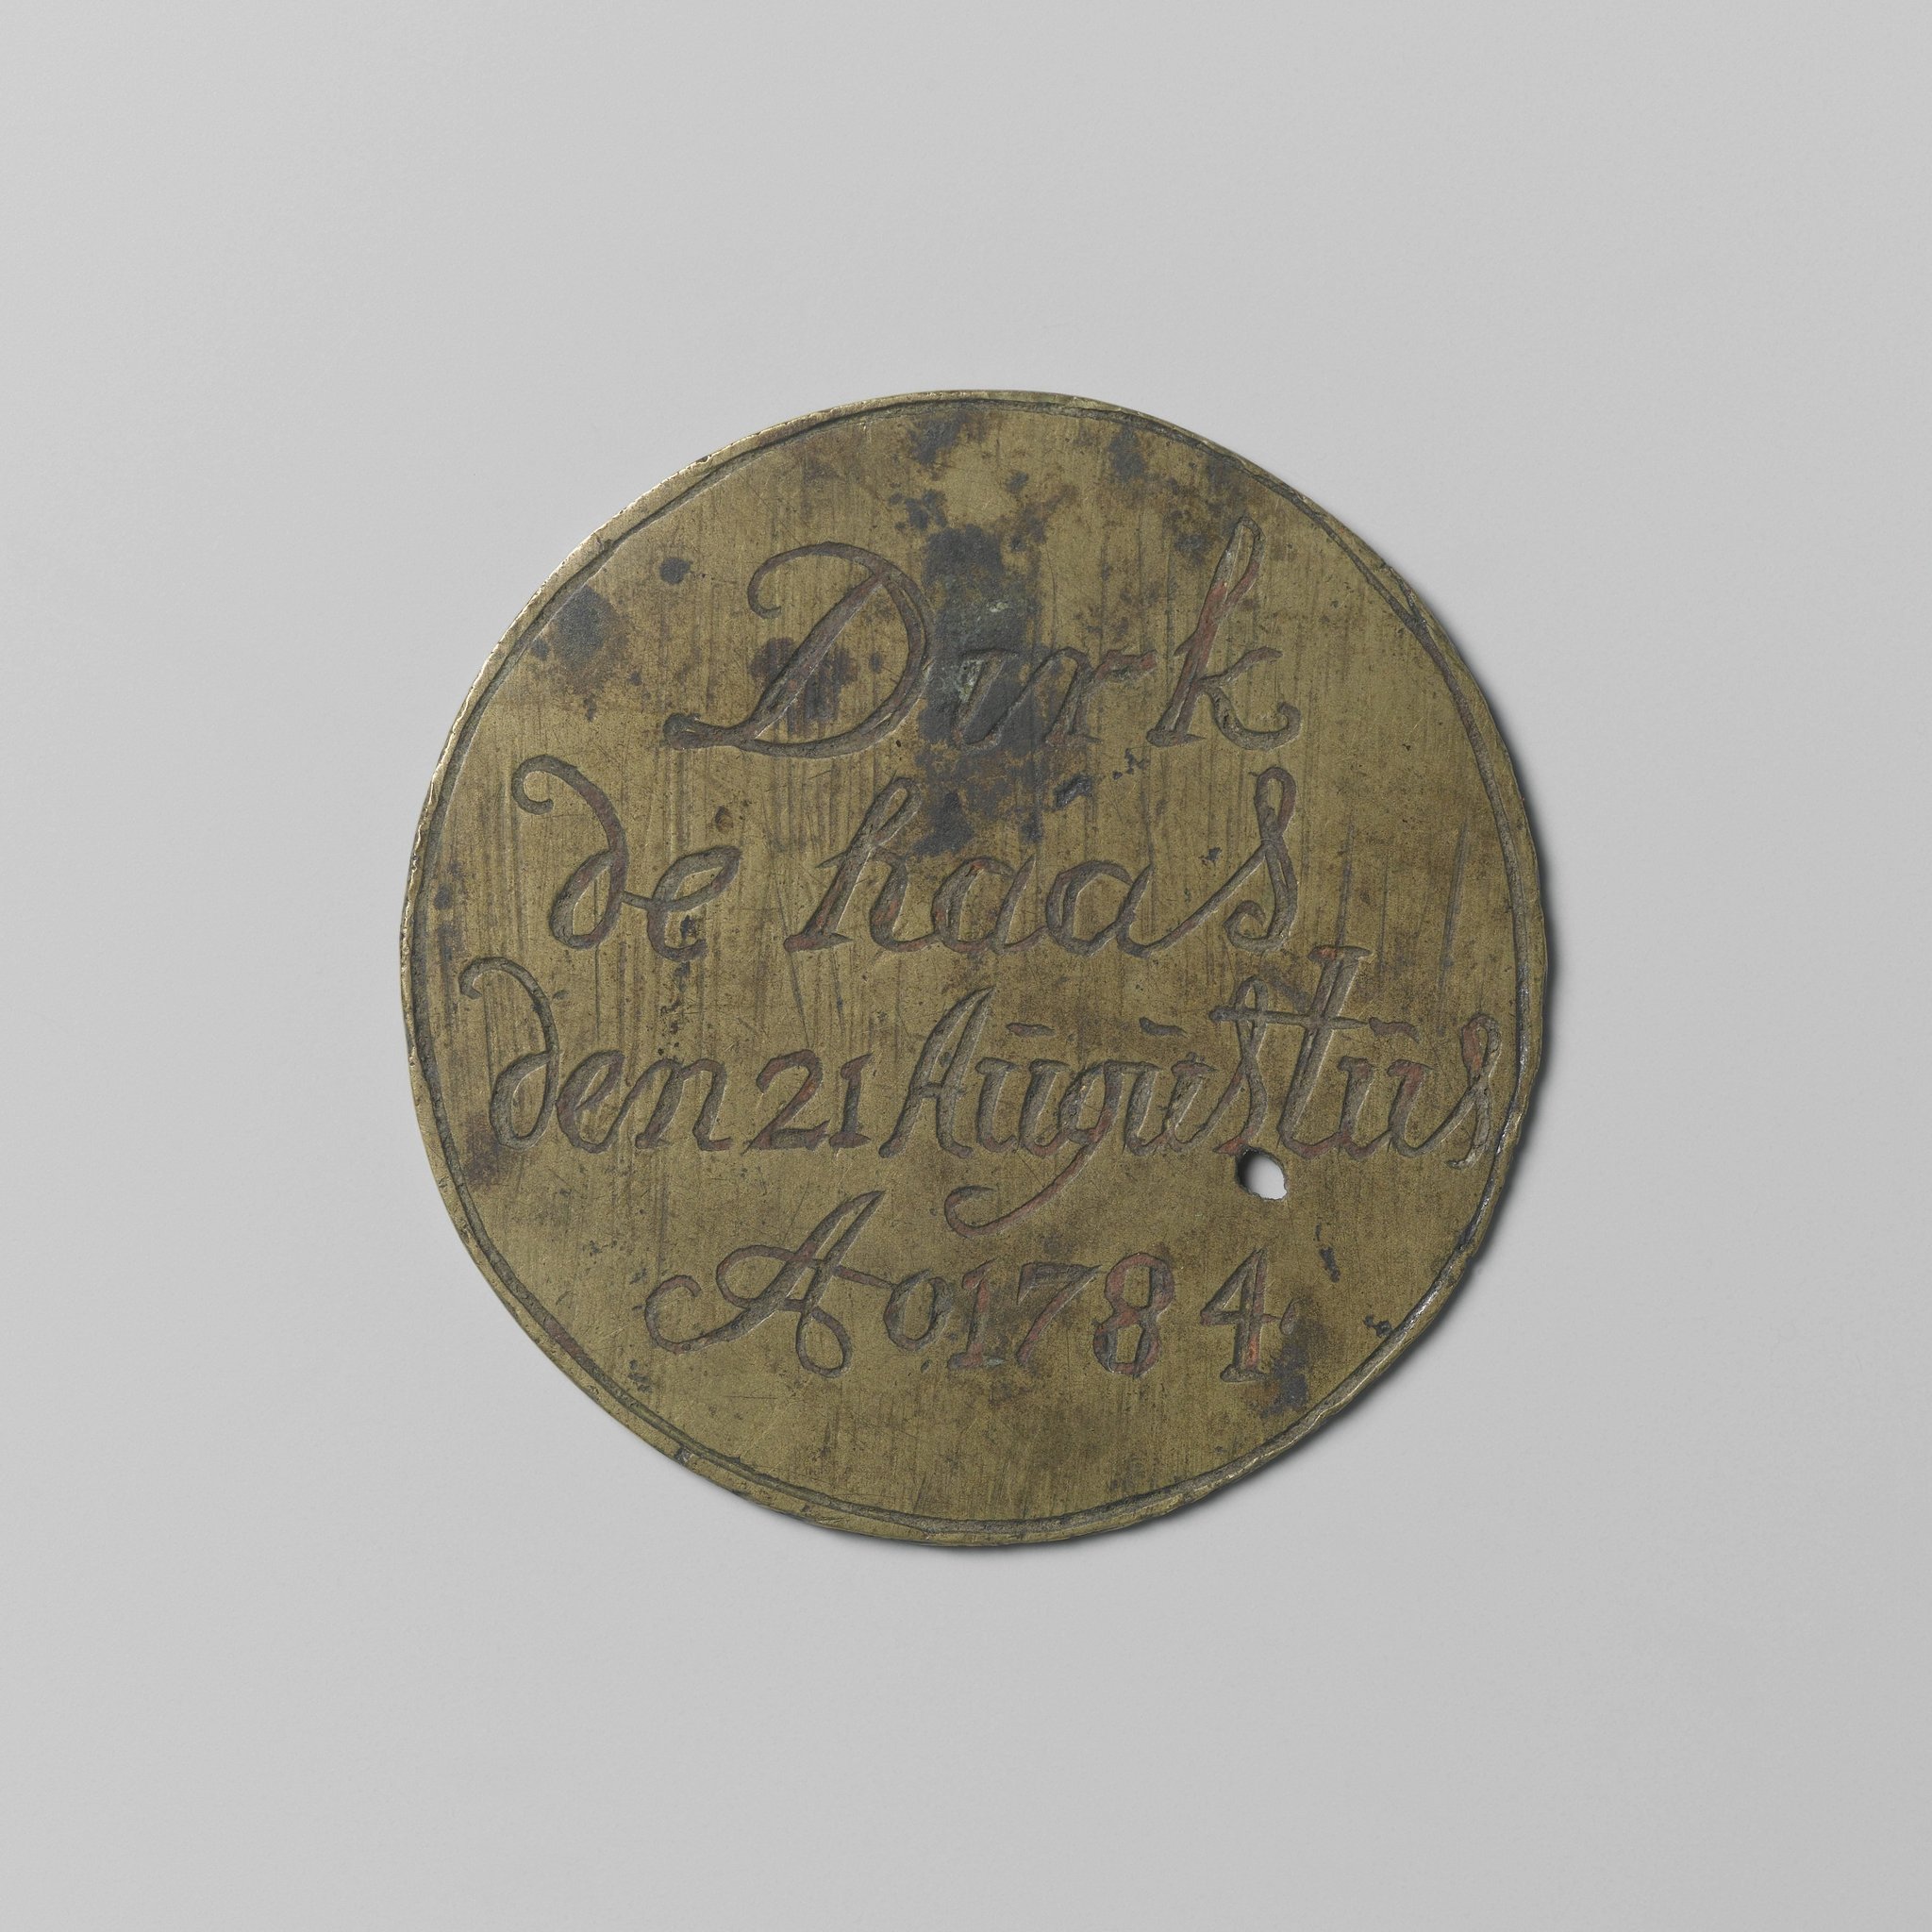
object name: medal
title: Vlotschuitvoerdersgilde van Amsterdam, gildepenning van Dirk de Haas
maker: Anonymous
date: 1784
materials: brass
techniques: engraving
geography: amsterdam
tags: amsterdam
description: Messing penning met gat erin. Voorzijde: schuit; daarboven twee naar links vliegende vogels. Keerzijde: opschrift boven jaartal